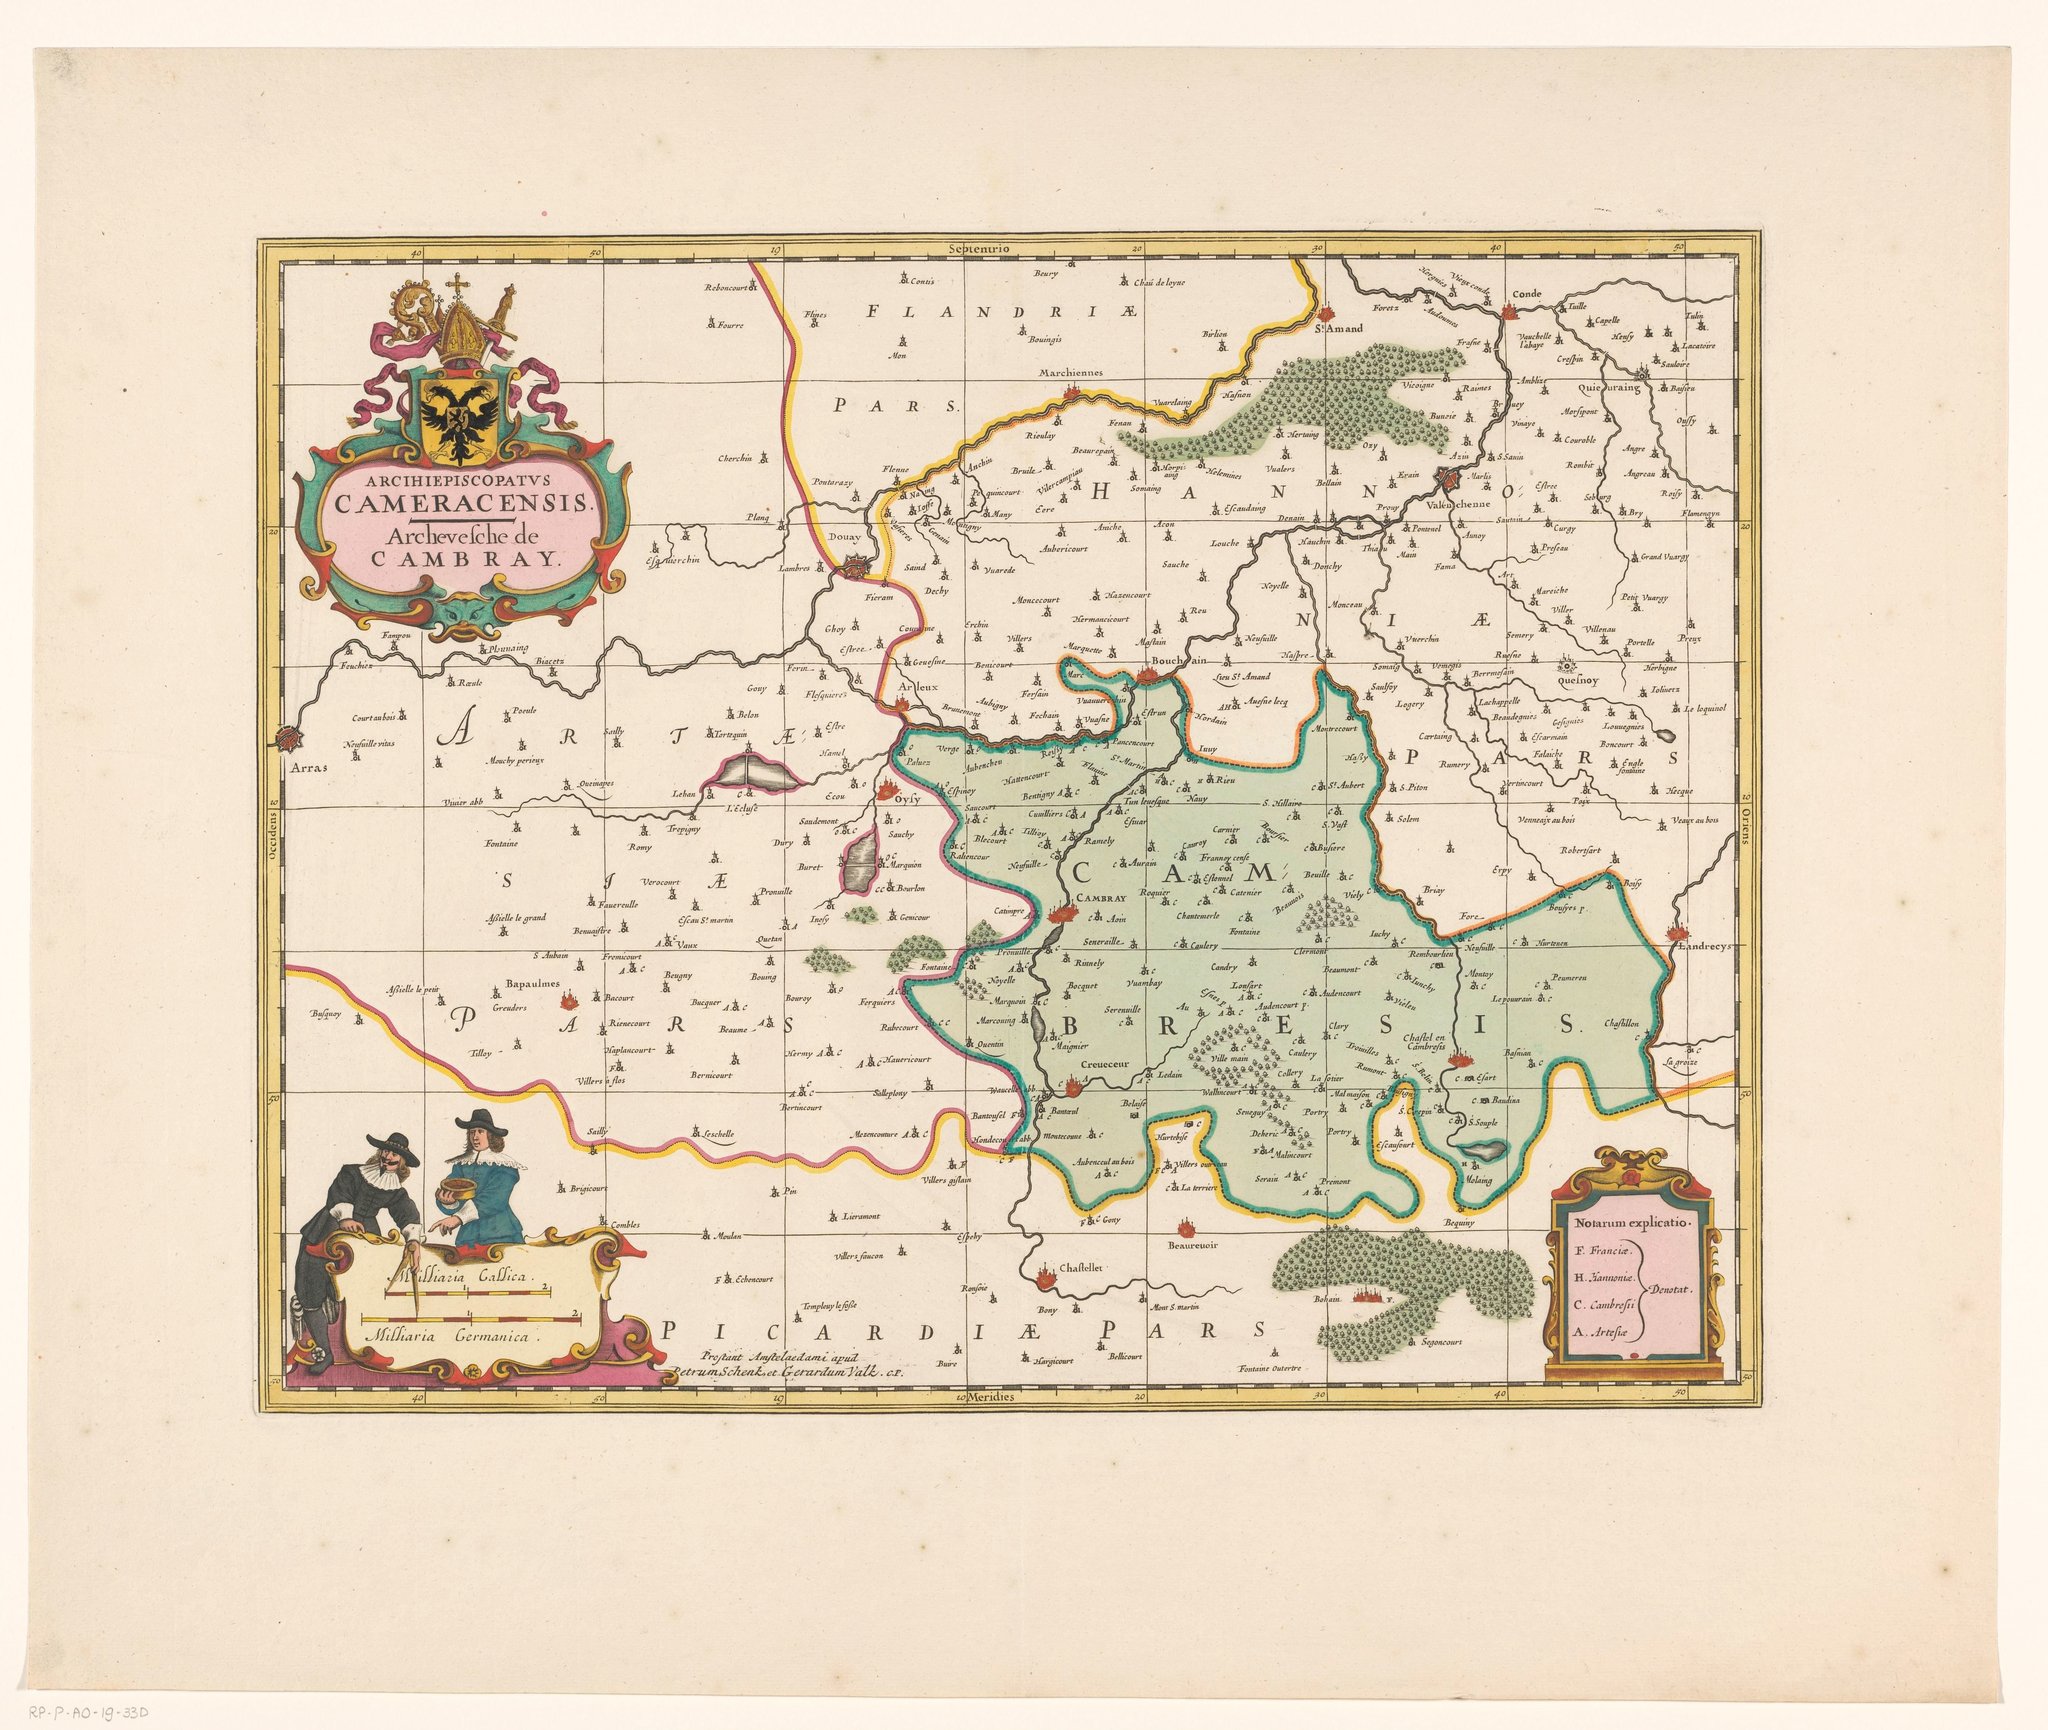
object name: map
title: Arcihiepiscopatus Cameracensis. Archevesche de Cambray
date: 1639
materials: paper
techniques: engraving, etching, hand coloring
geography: amsterdam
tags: maps of separate countries or regions, coat of arms (as symbol of the state, etc.) (+ province; provincial), instruments used in geodesy, surveying instruments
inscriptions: collector's mark: Lugt 2228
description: Kaart van het aartsbisdom Kamerijk. Linksboven de titelcartouche met bovenin het wapen van het aartsbisdom Kamerijk. Linksonder een cartouche, met daarbij twee figuren met meetkundige instrumenten, met twee schaalstokken: 2 Milliaria Gallica / 2 Milliaria Germanica. Rechtsonder een cartouche met uitleg van de afkortingen op de kaart. De kaart is voorzien van een coördinaten-net en een gradenverdeling langs de randen.